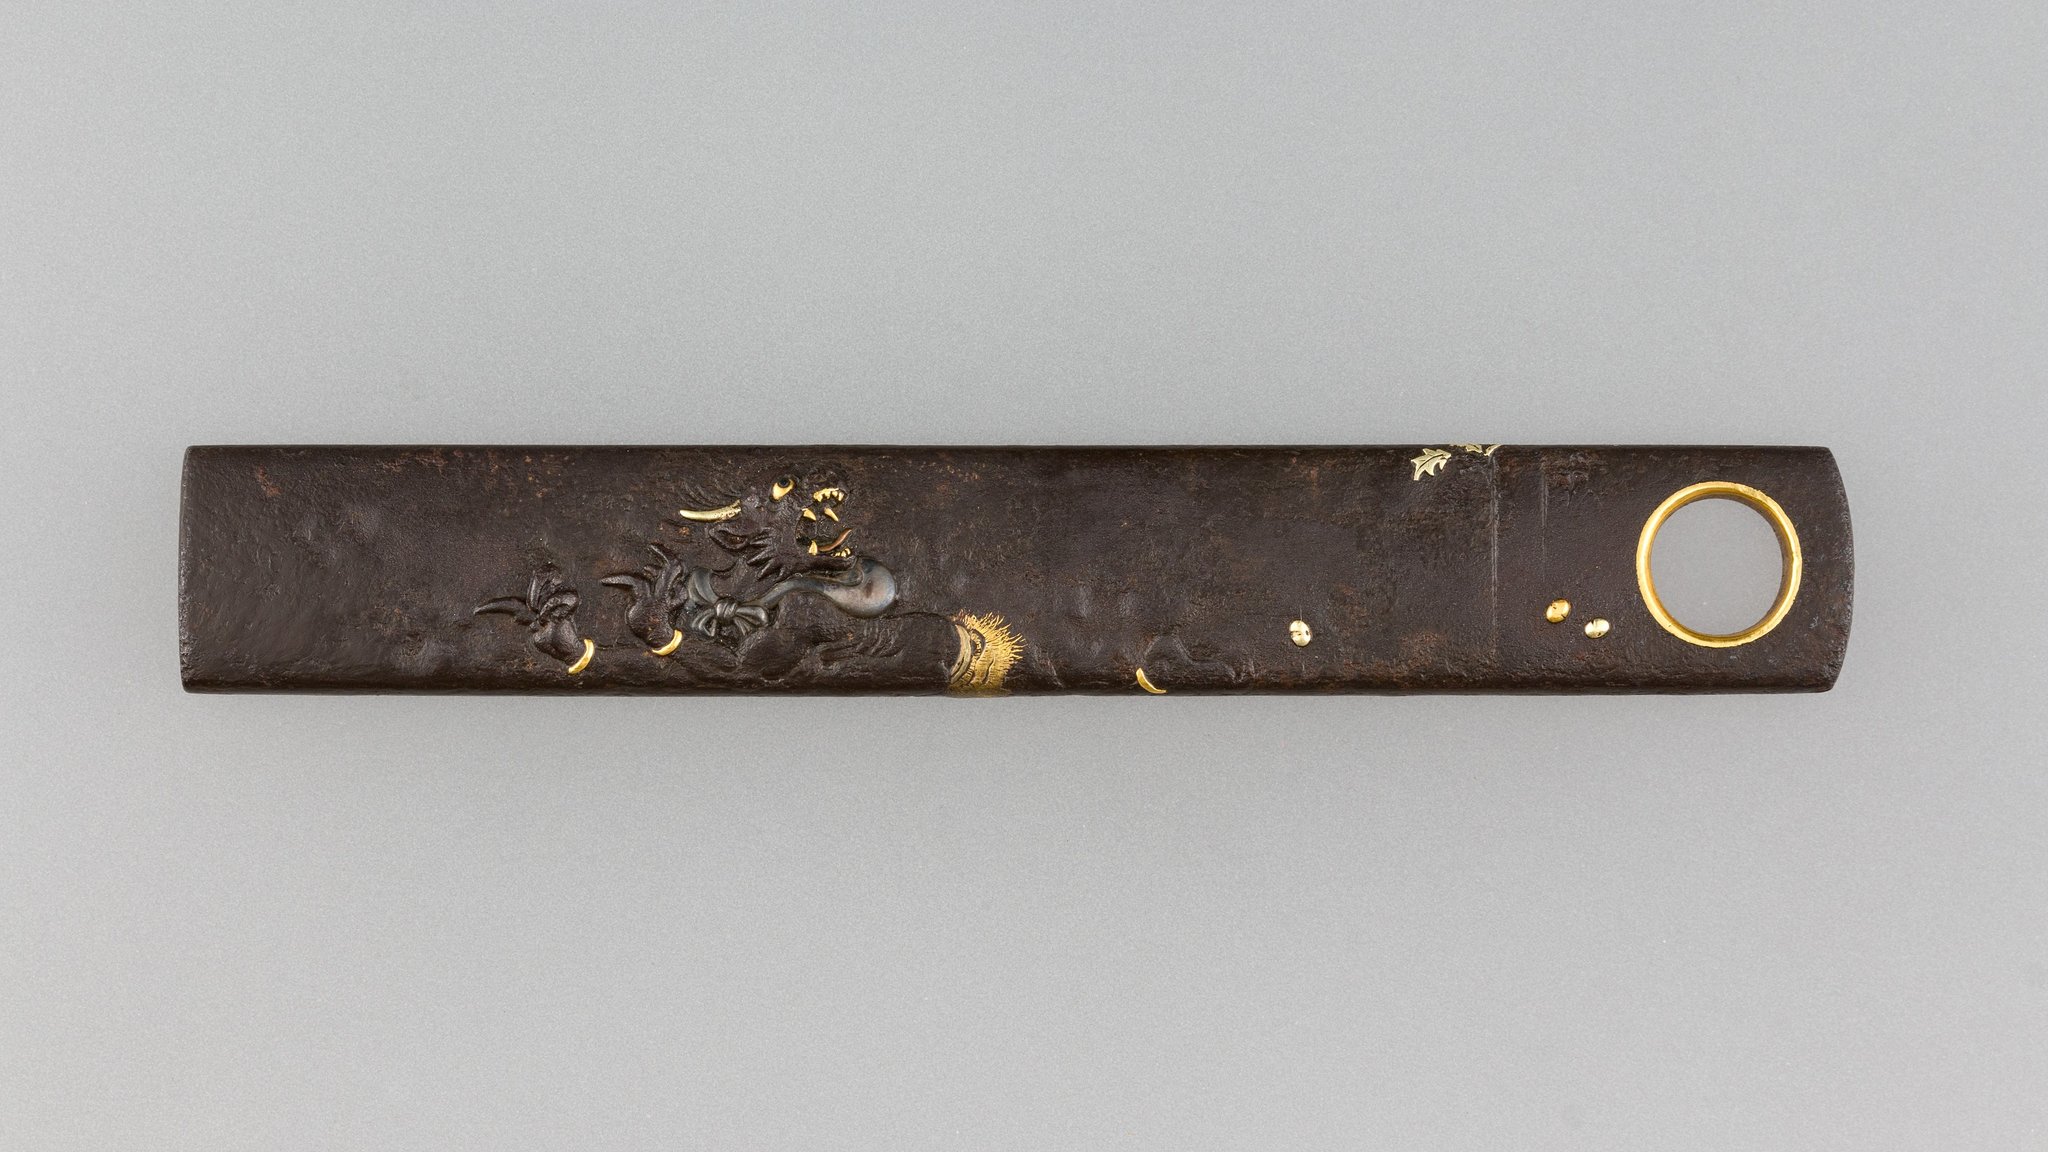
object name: knife handle kozuka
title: Knife Handle (Kozuka)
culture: japanese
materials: copper, gold alloy, silver alloy, gold, iron, silver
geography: japan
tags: mythical creatures